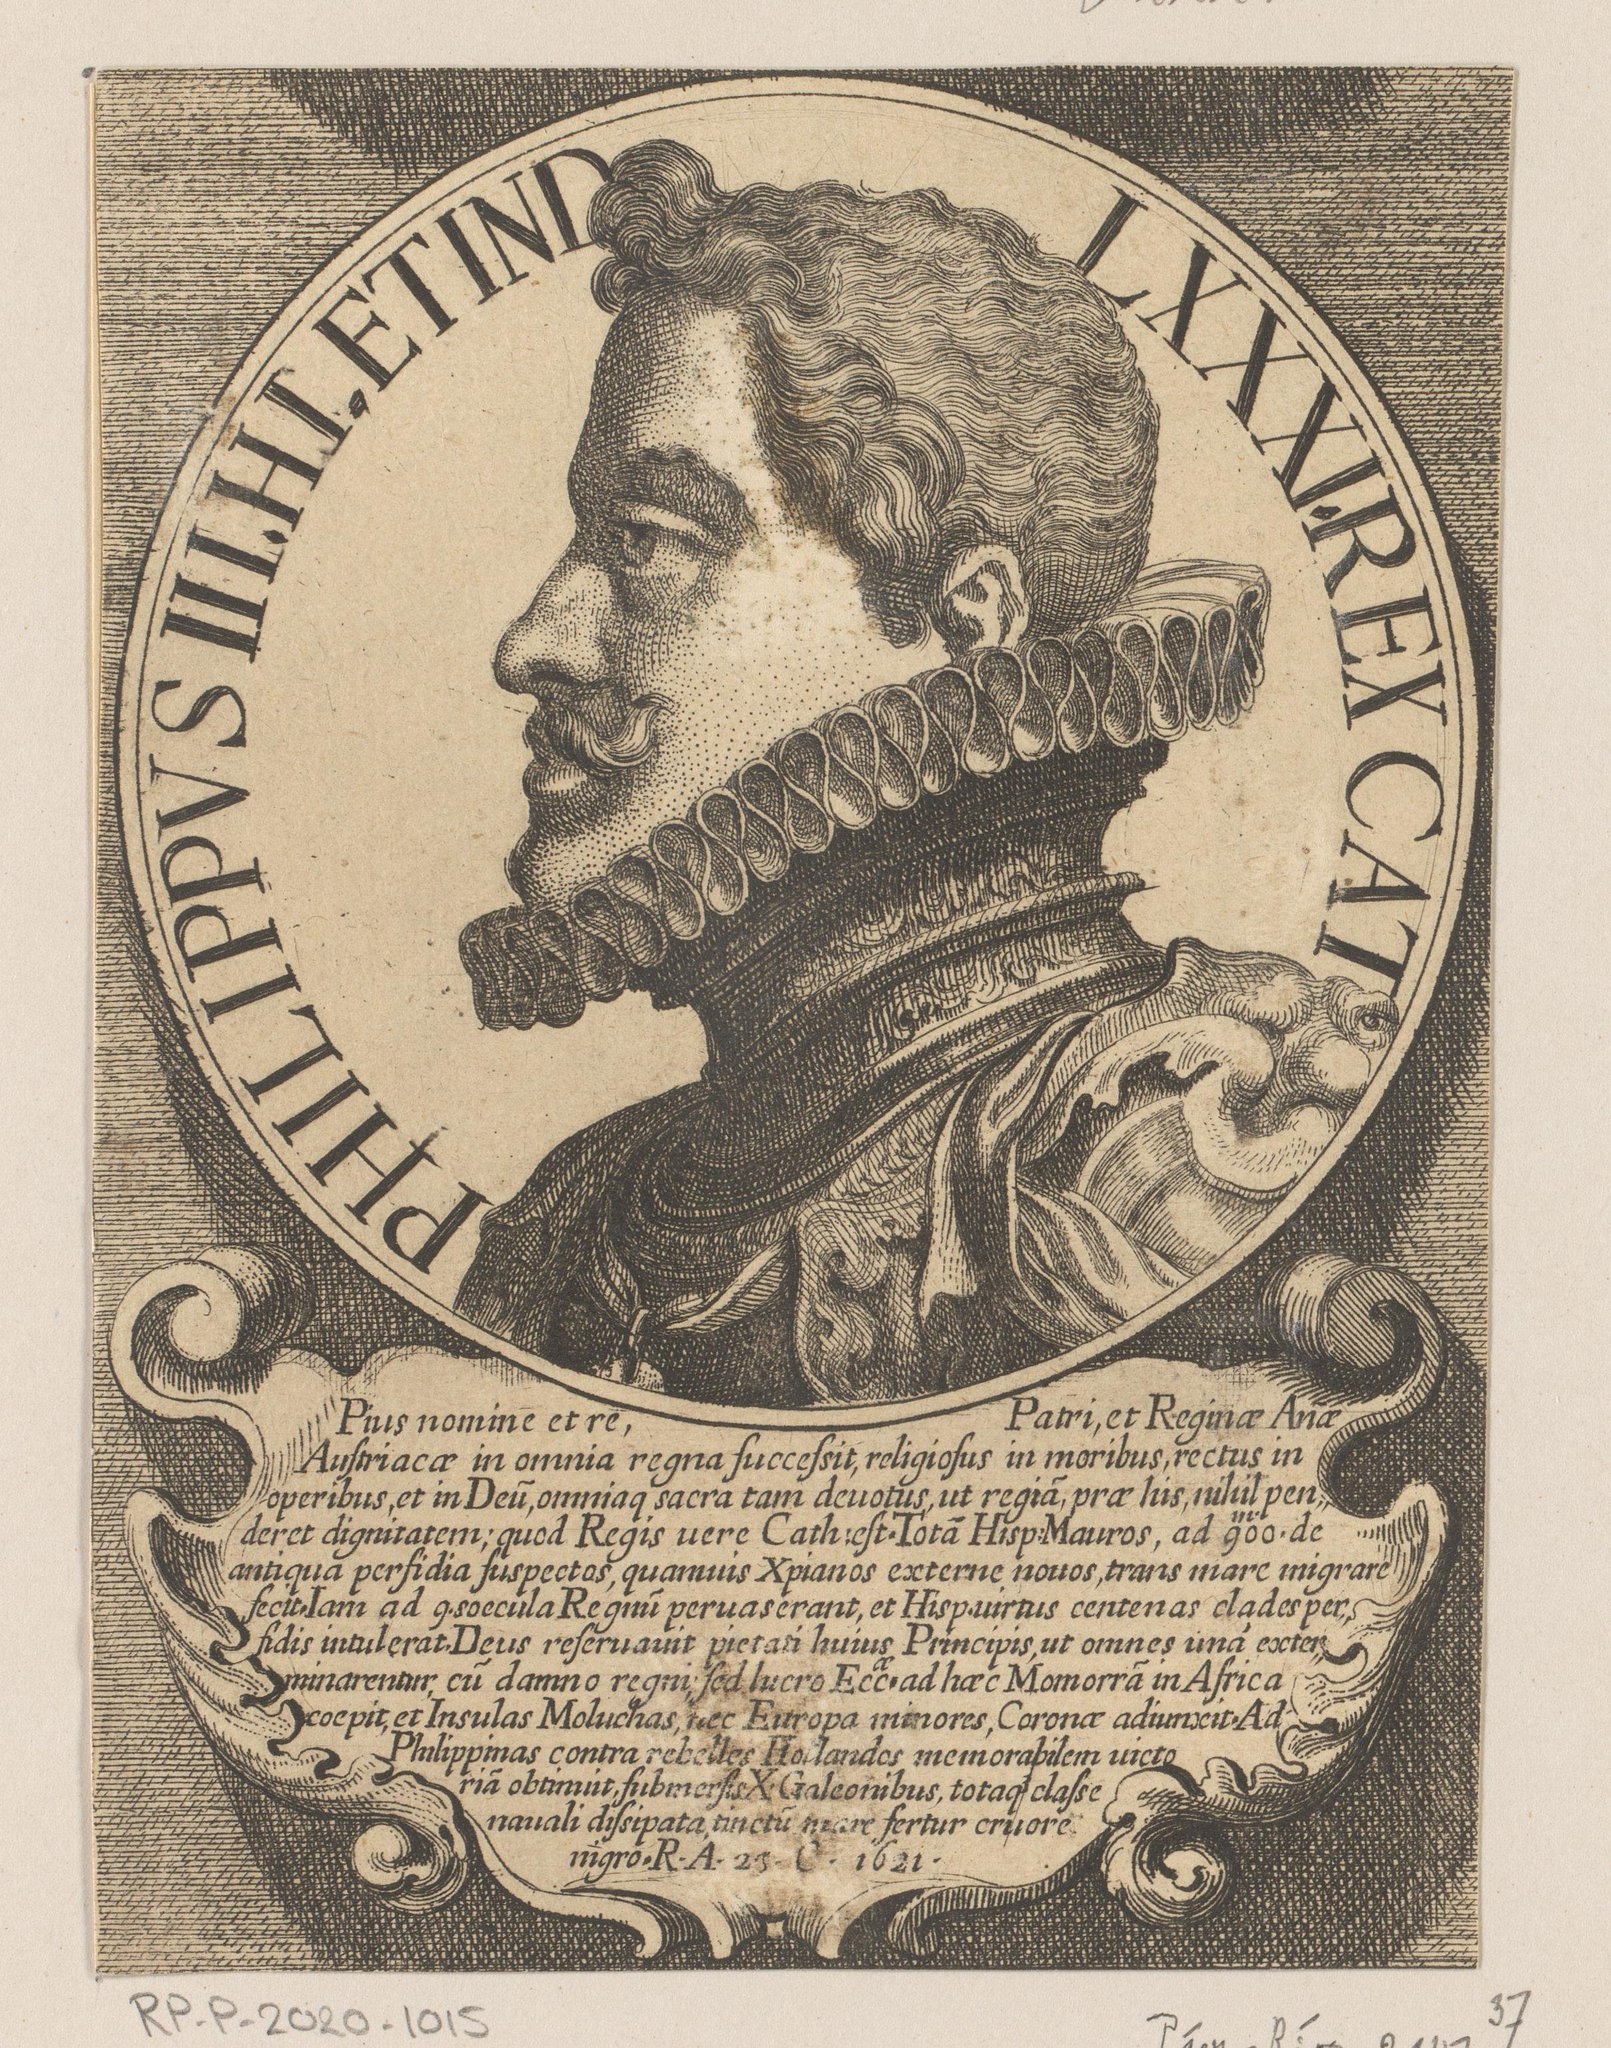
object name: print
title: Philippus III Hi Etind LXXXI Rex Cat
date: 1684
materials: paper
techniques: engraving, etching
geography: rome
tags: philip ii of spain, historical persons, ruler, sovereign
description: Portret mogelijk afkomstig van een grote prent, getiteld 'Effigies et series regum Hispaniae primum ex Gothis Christianorum (...)', bestaande uit meerdere bladen die samengevoegd konden worden, uitgegeven door Giovanni Giacomo de' Rossi in 1684.